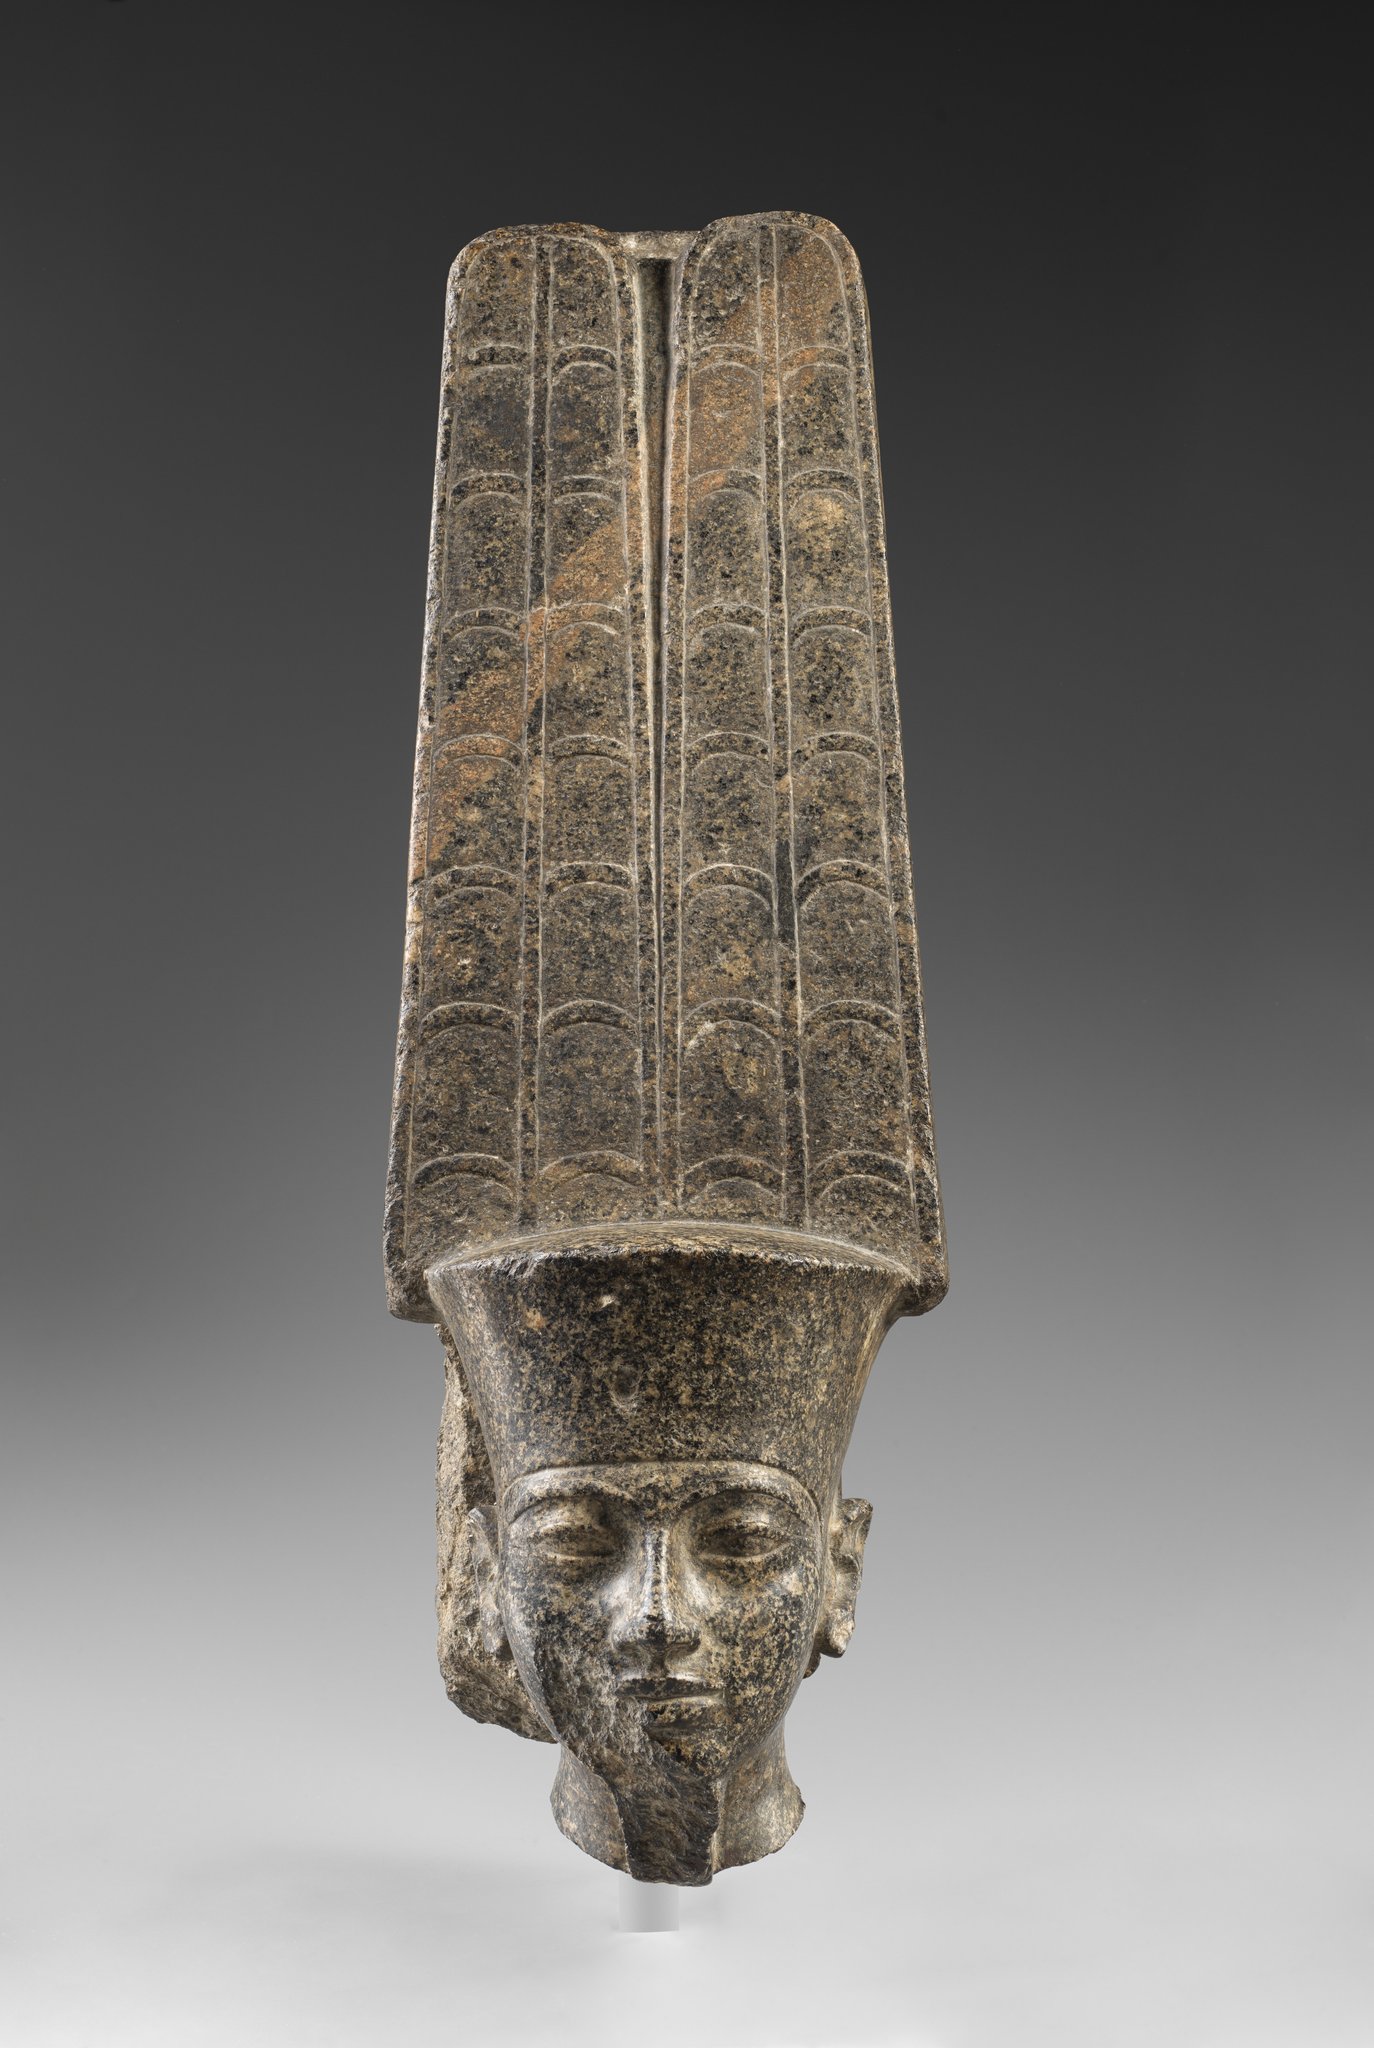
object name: head, amun, feather crown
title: Head of Amun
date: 1336-1295 BCE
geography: upper egypt, thebes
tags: amun